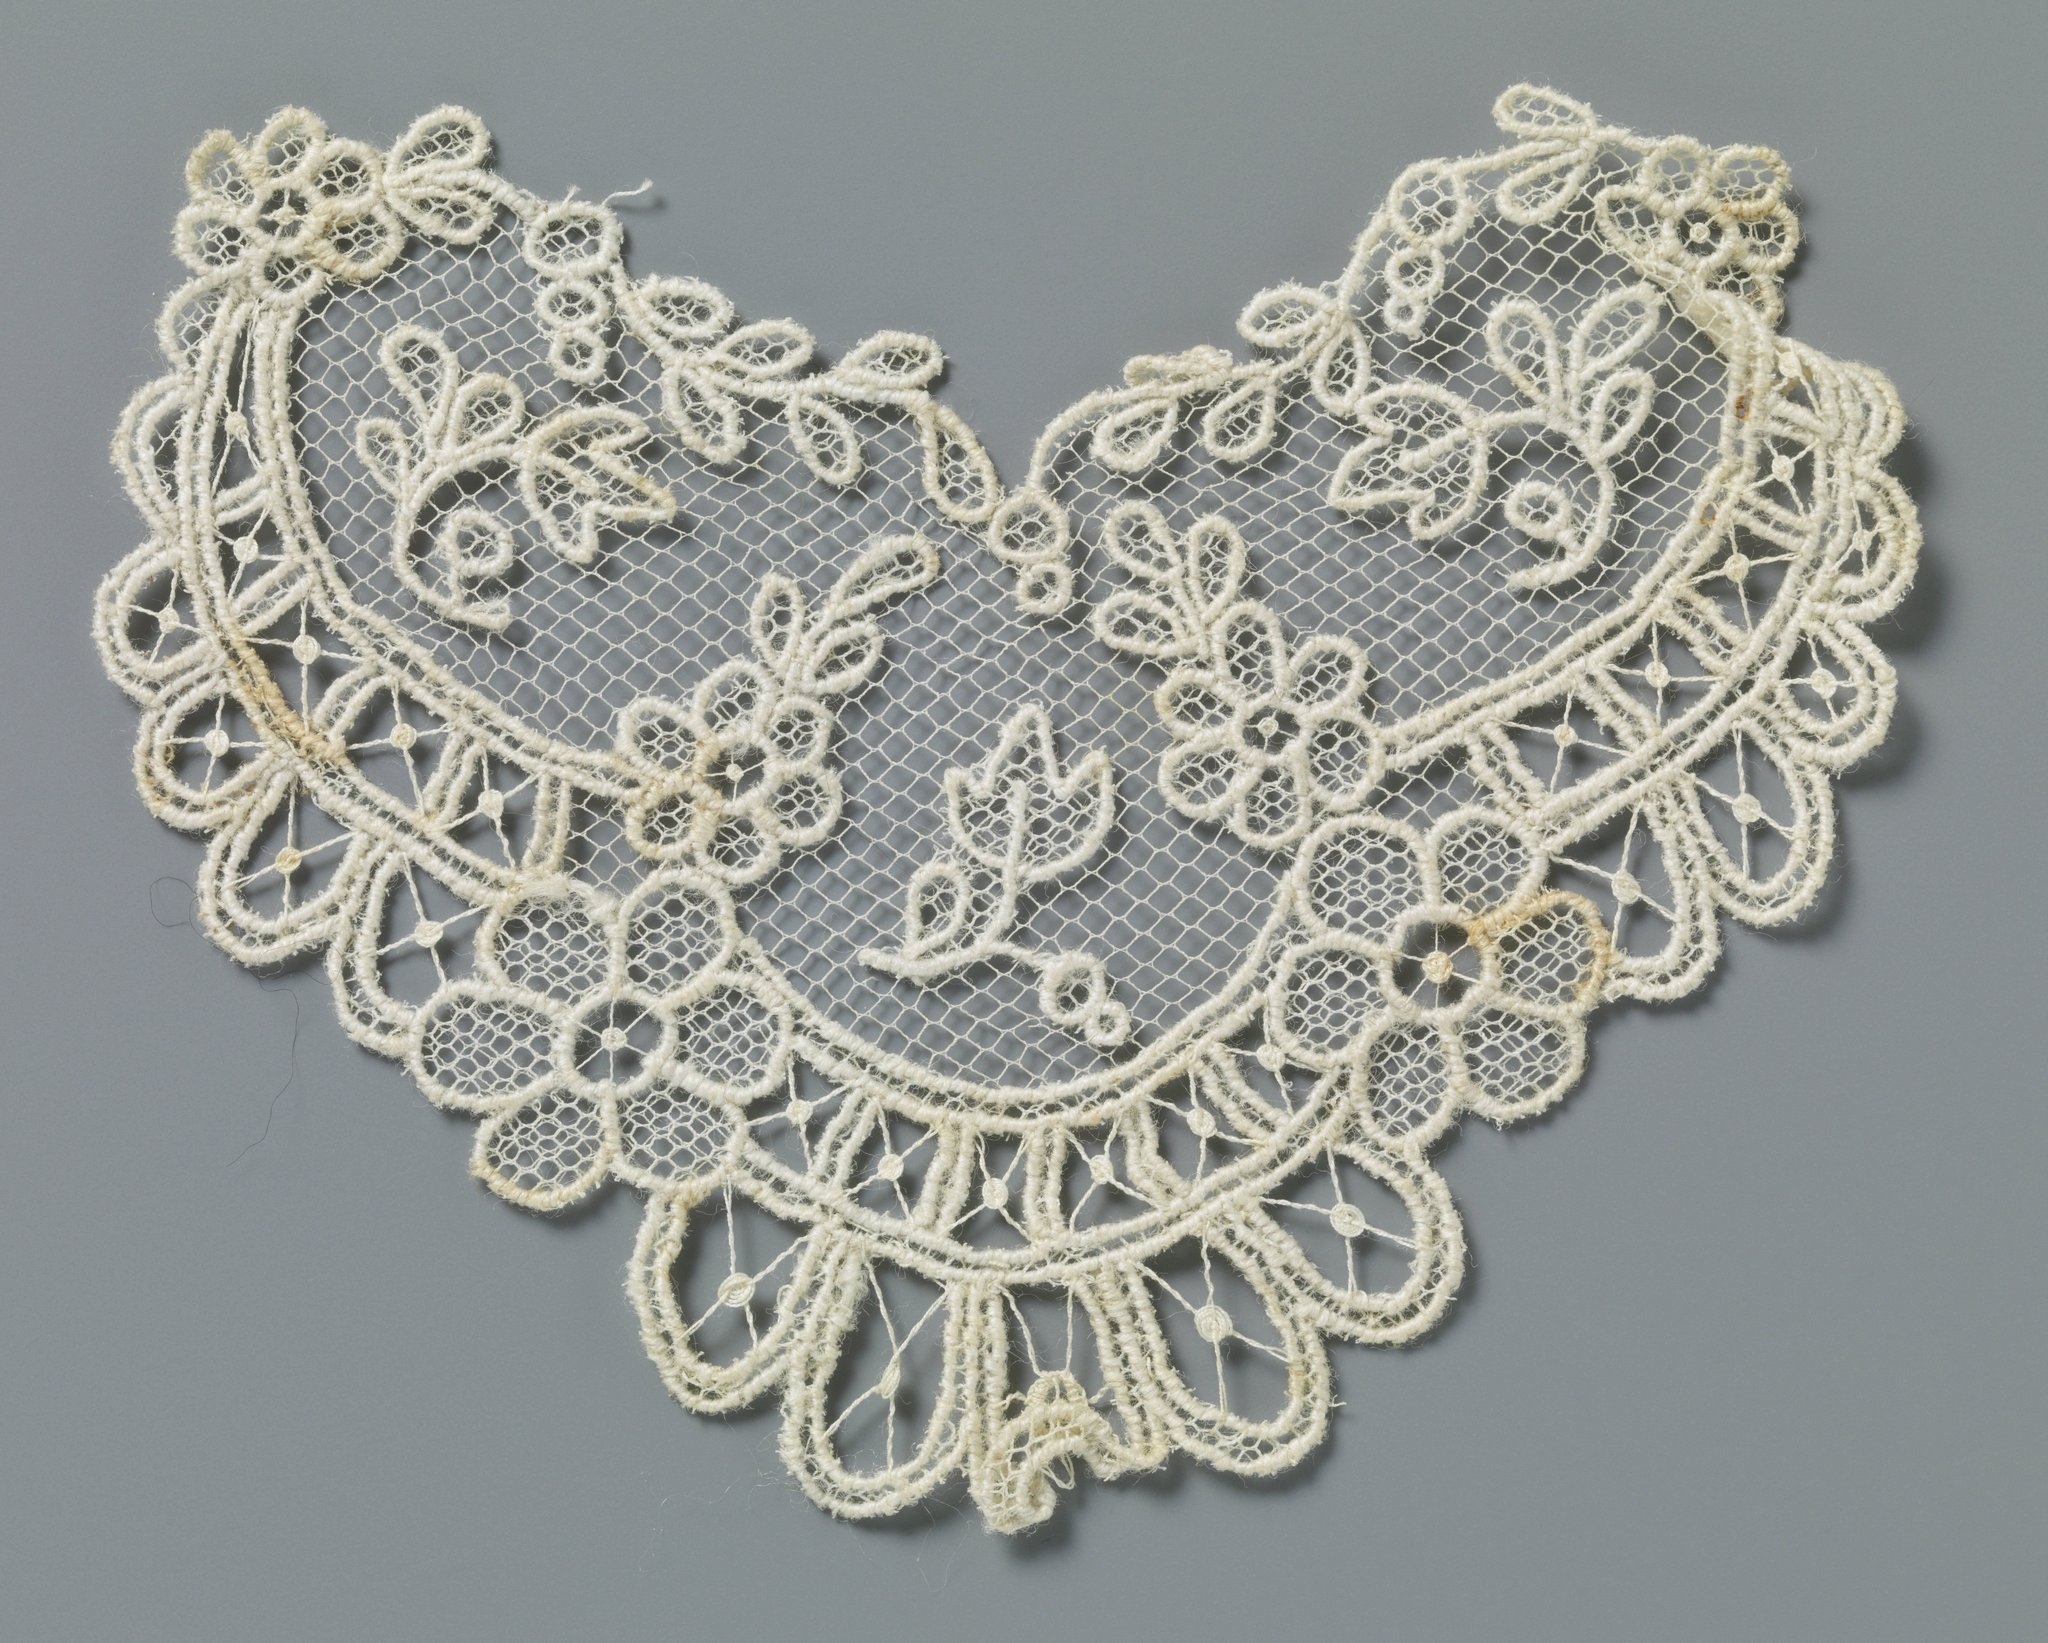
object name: applicatie textiel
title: Applicatie met hartvorm van machinale kant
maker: Anonymous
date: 1850-1899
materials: cotton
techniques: lace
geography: europe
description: Applicatie van naturelkleurige machinale kant. Hartvormig model. Het symmetrische patroon bestaat uit een sierrand langs de onderzijde van het hart van opengewerkte vierkantjes met in elk vierkant een kruisje met een stip in het centrum. Langs deze band hangen halfovaalvormige schulpen naar beneden met dezelfde kruisjes. De vierkantjes en schulpjes nemen richting de punt aan de onderkant in grootte toe. Aan de bovenkant wordt het hart begrensd door een rank met kleine blaadjes. In het hart staan drie kelkbloempjes met twee rozetbloempjes ertussen, beiden met kleine blaadjes.